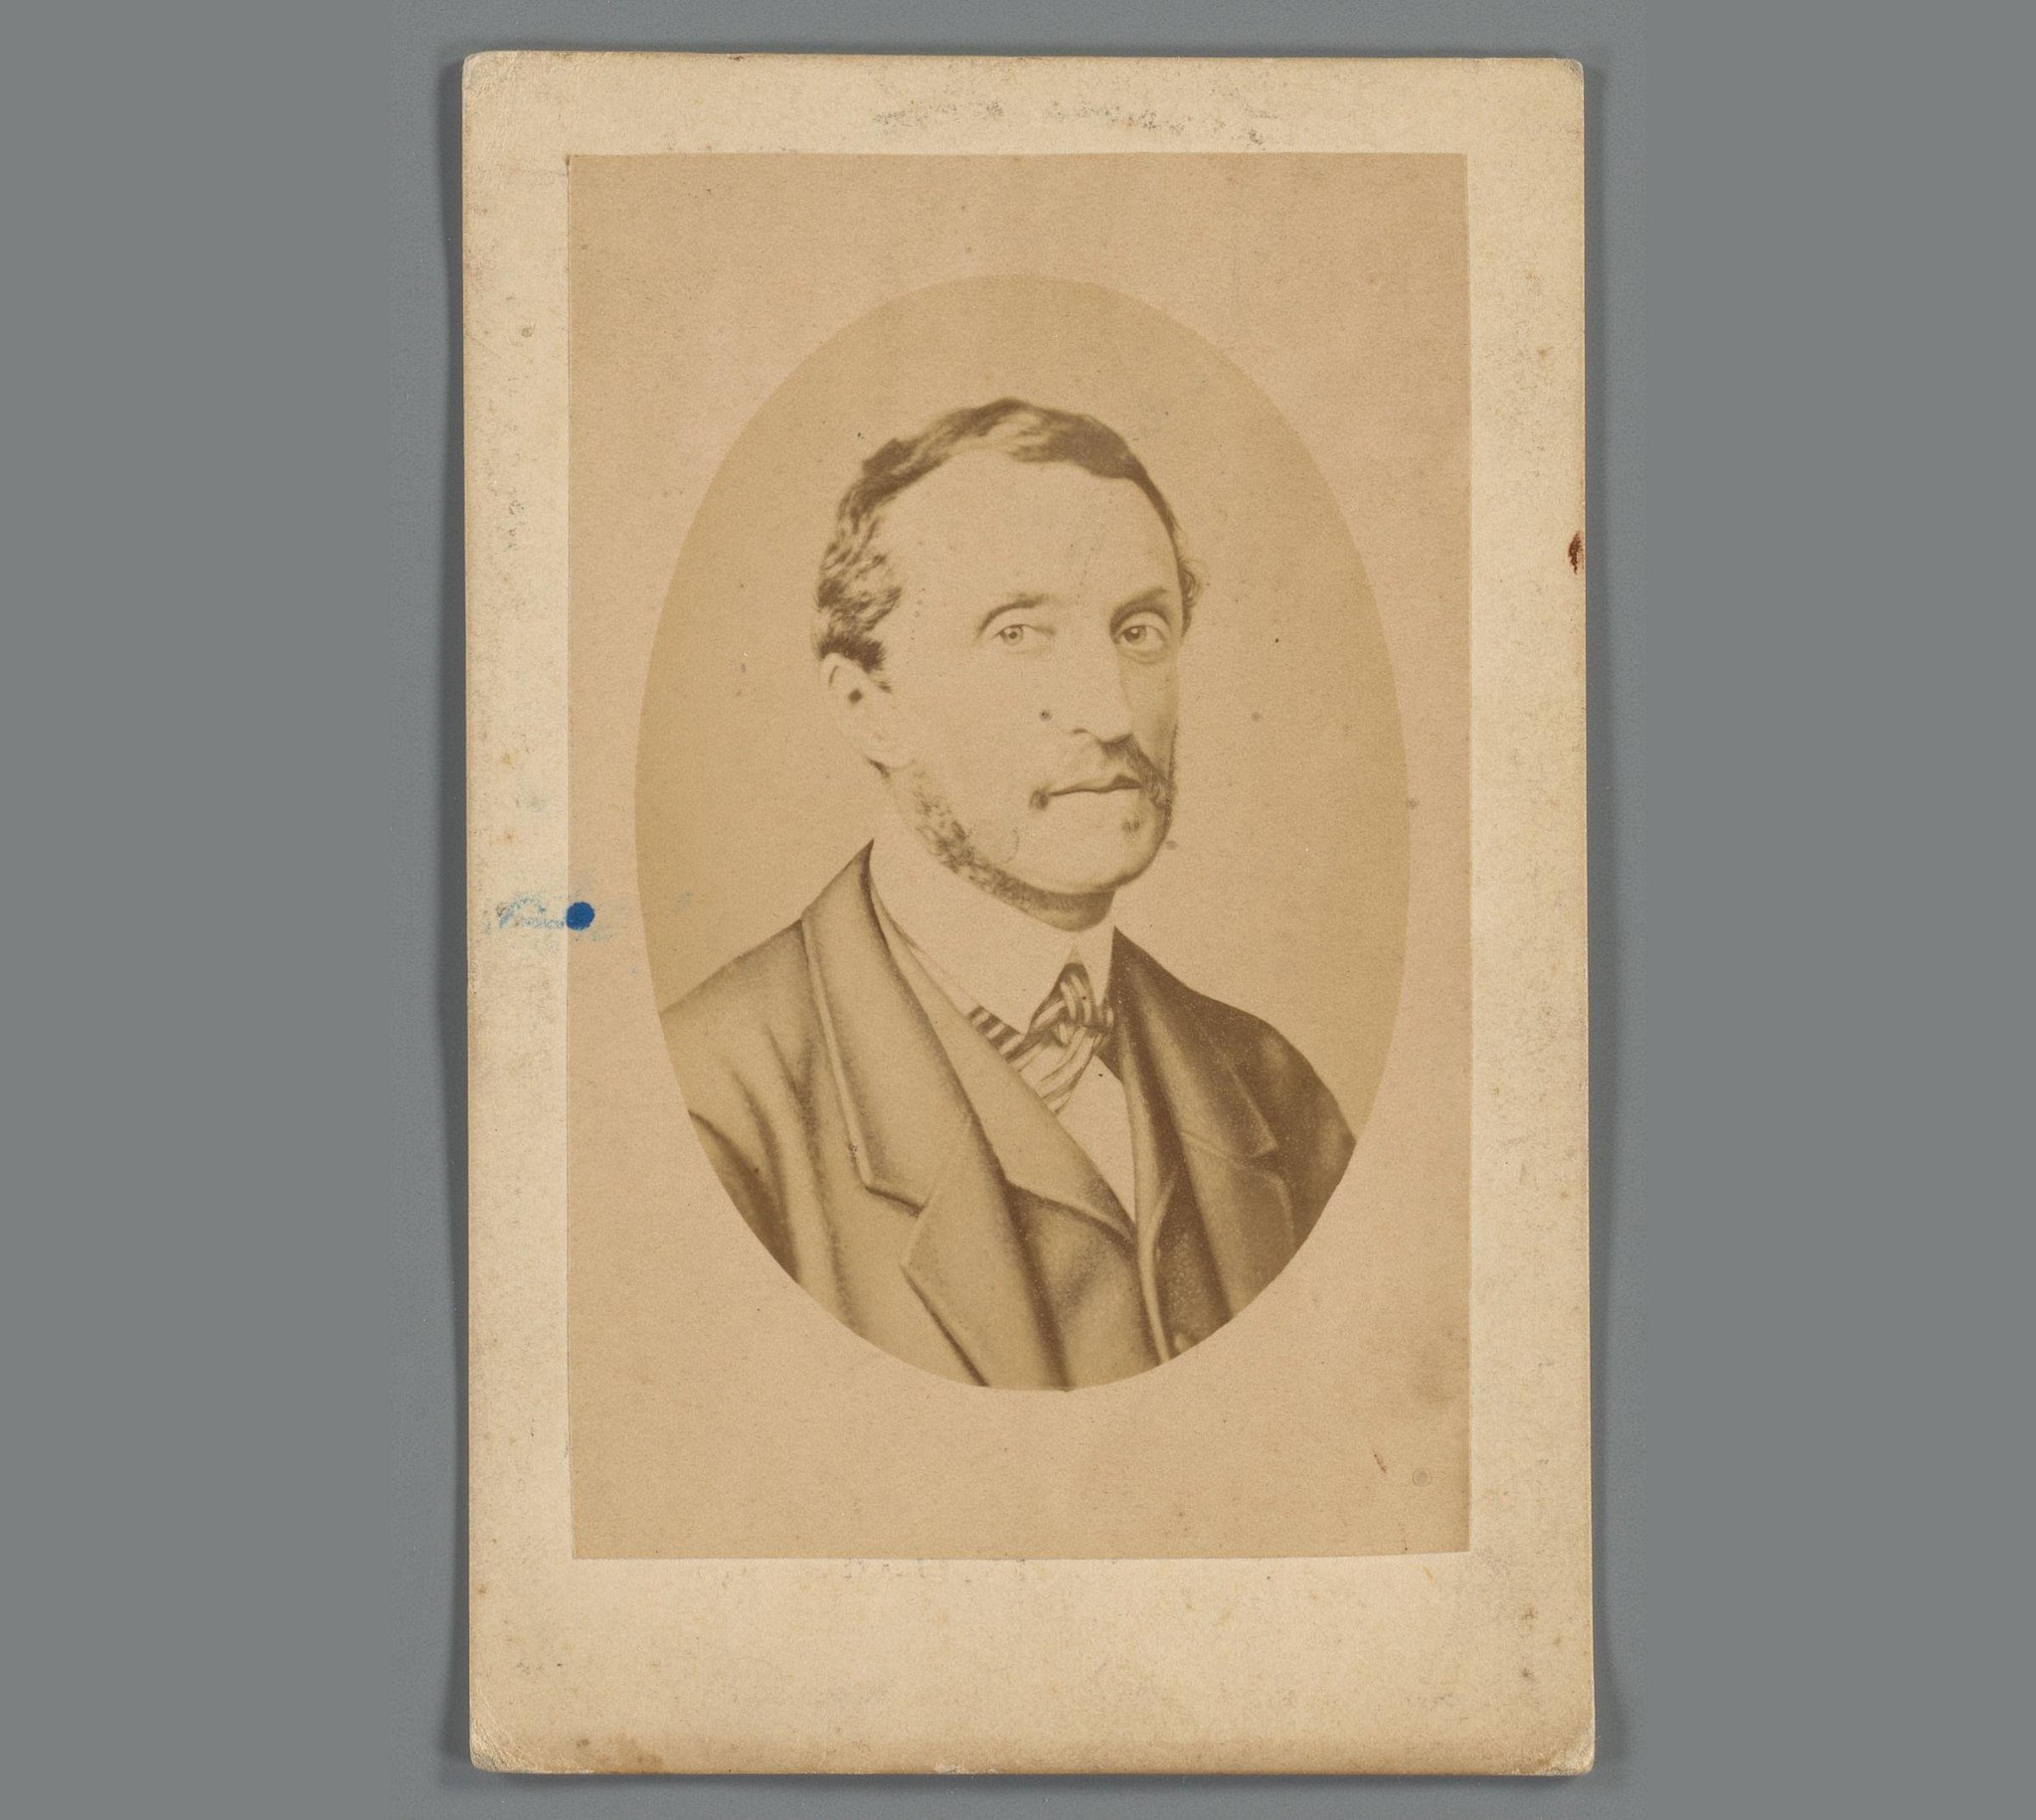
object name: prayer card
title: Portret van Antonio Francesco Taddei op bidprent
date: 1875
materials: cardboard, paper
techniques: albumen print, lithograph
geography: trento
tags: adult man, historical persons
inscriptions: inscription: ‘Parenti amici/ pregate i beni imperituri (...) questa memoria porgono./ Lit. G. Zippel Trento.’